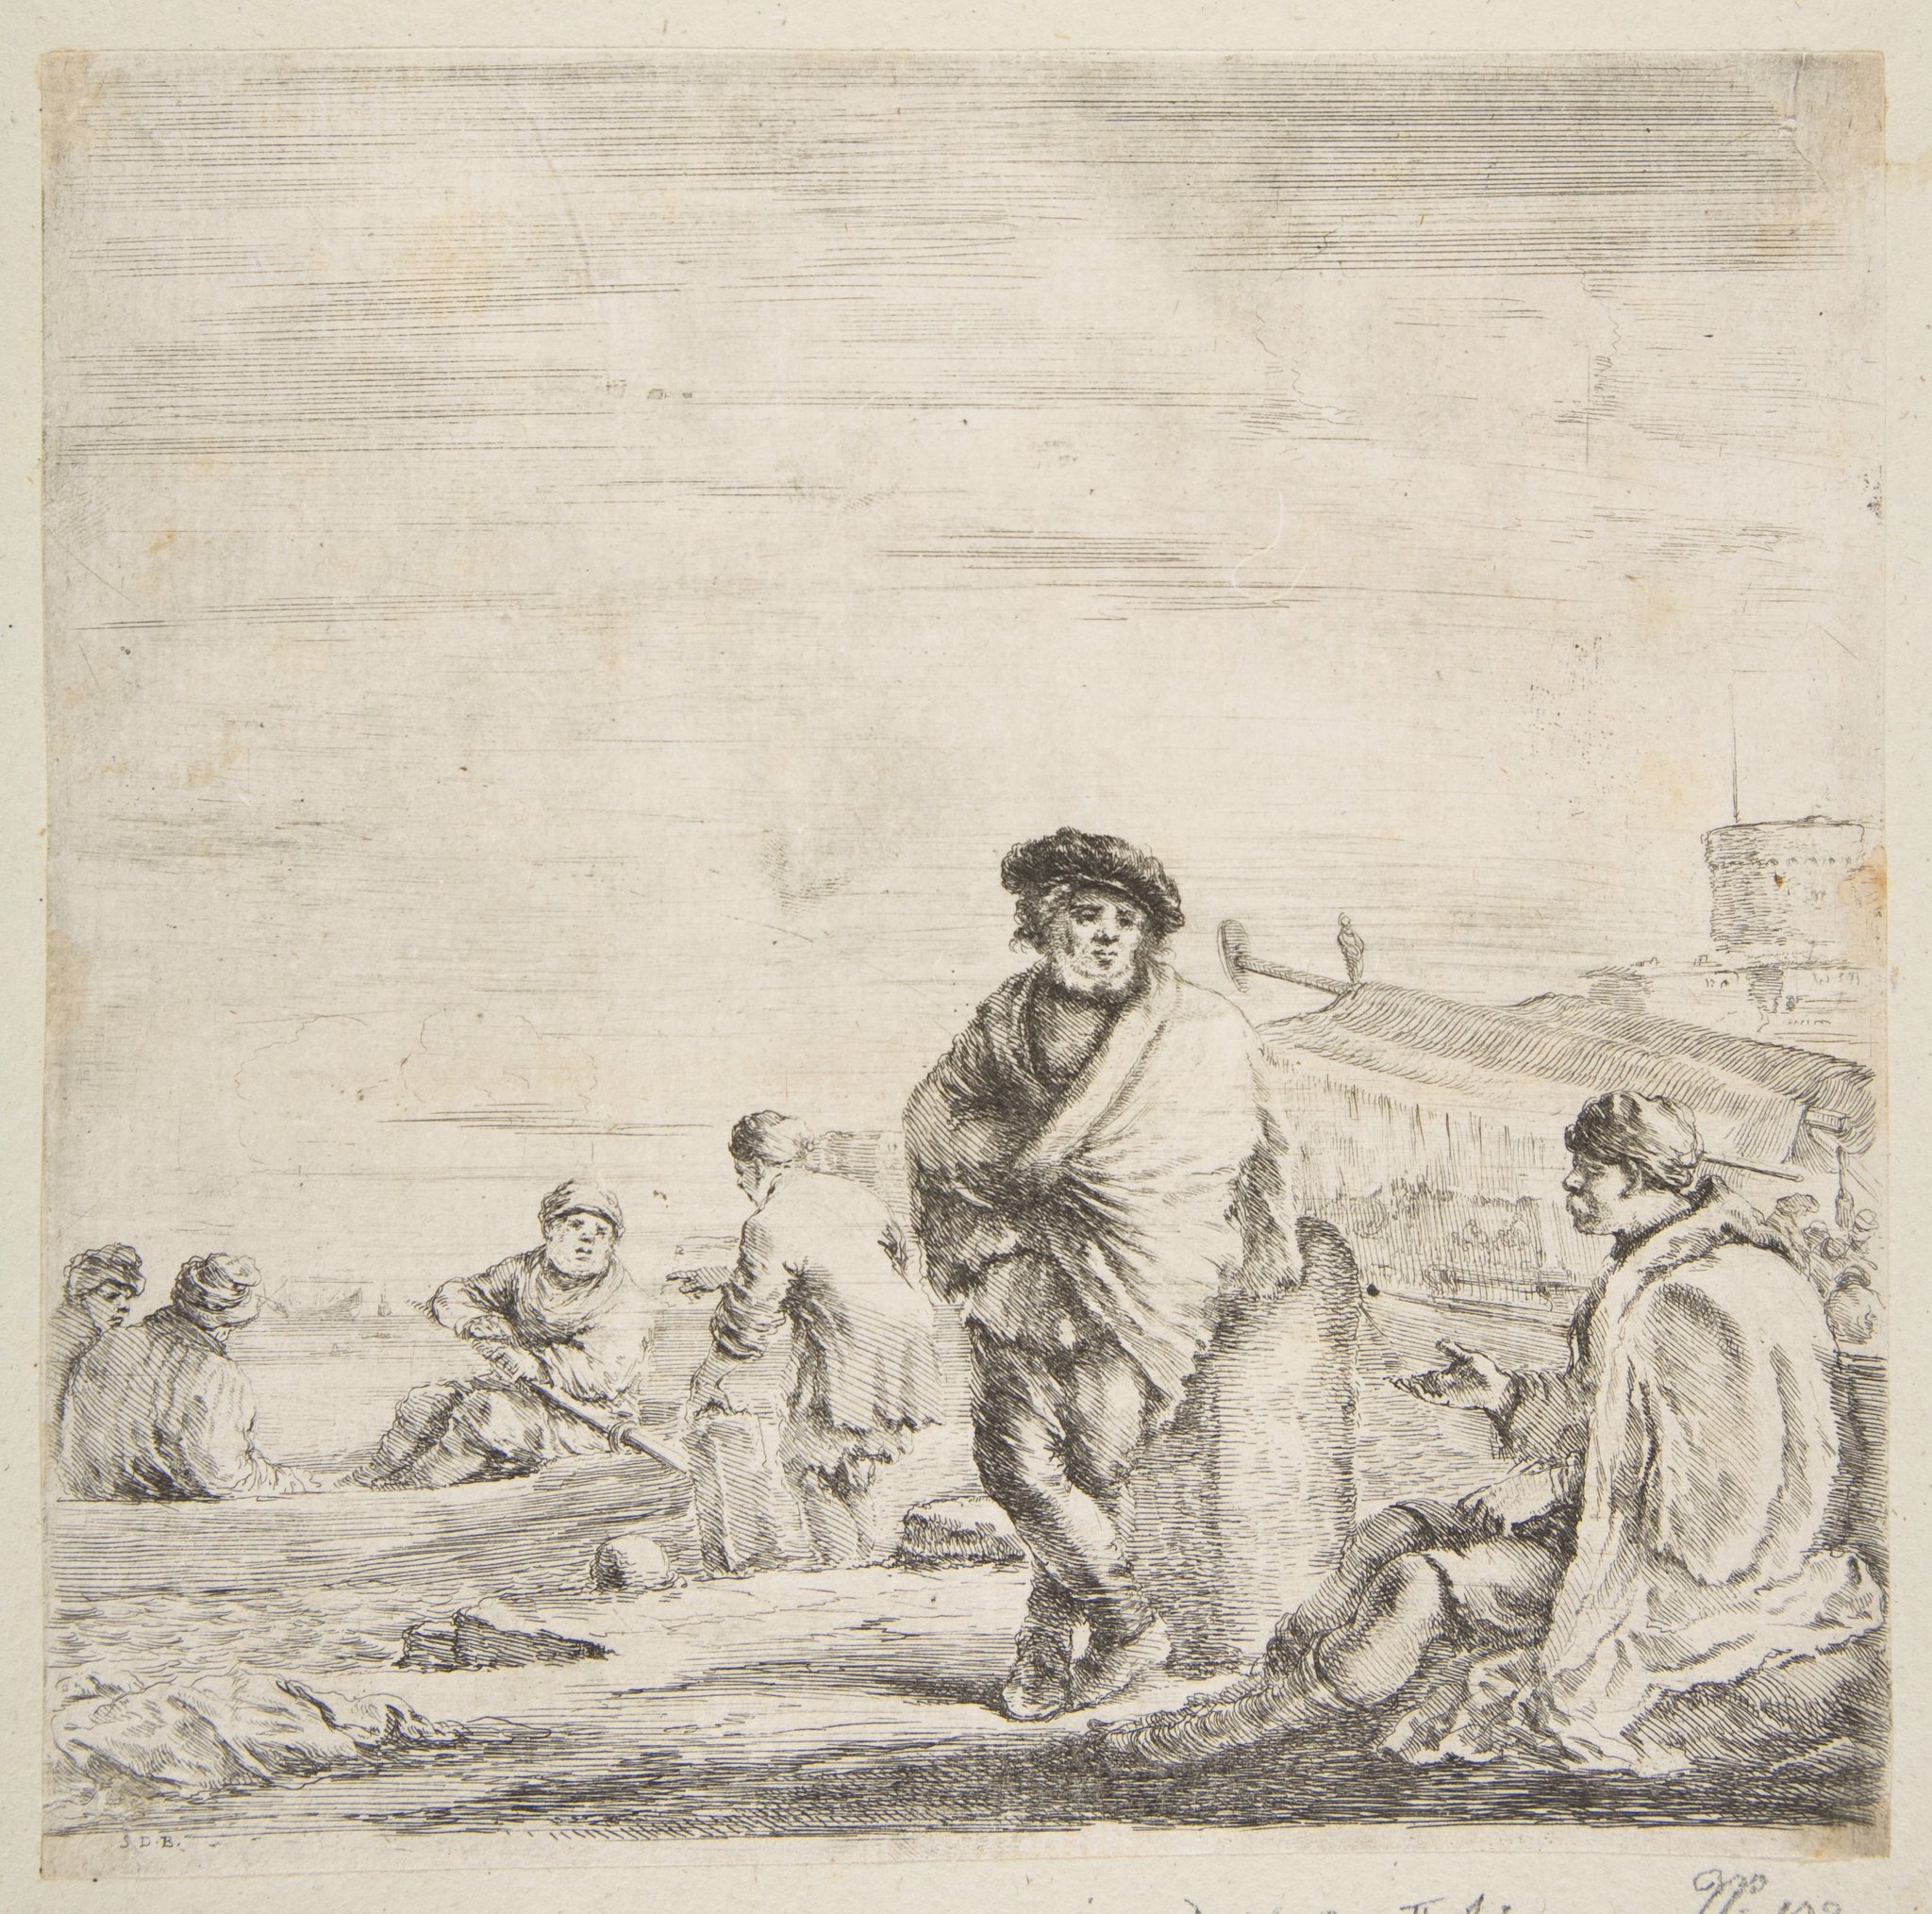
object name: print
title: A standing sailor talking to a seated Levantine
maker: stefano della bella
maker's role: artist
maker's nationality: italian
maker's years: 1610-1664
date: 1660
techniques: etching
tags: men,sailors